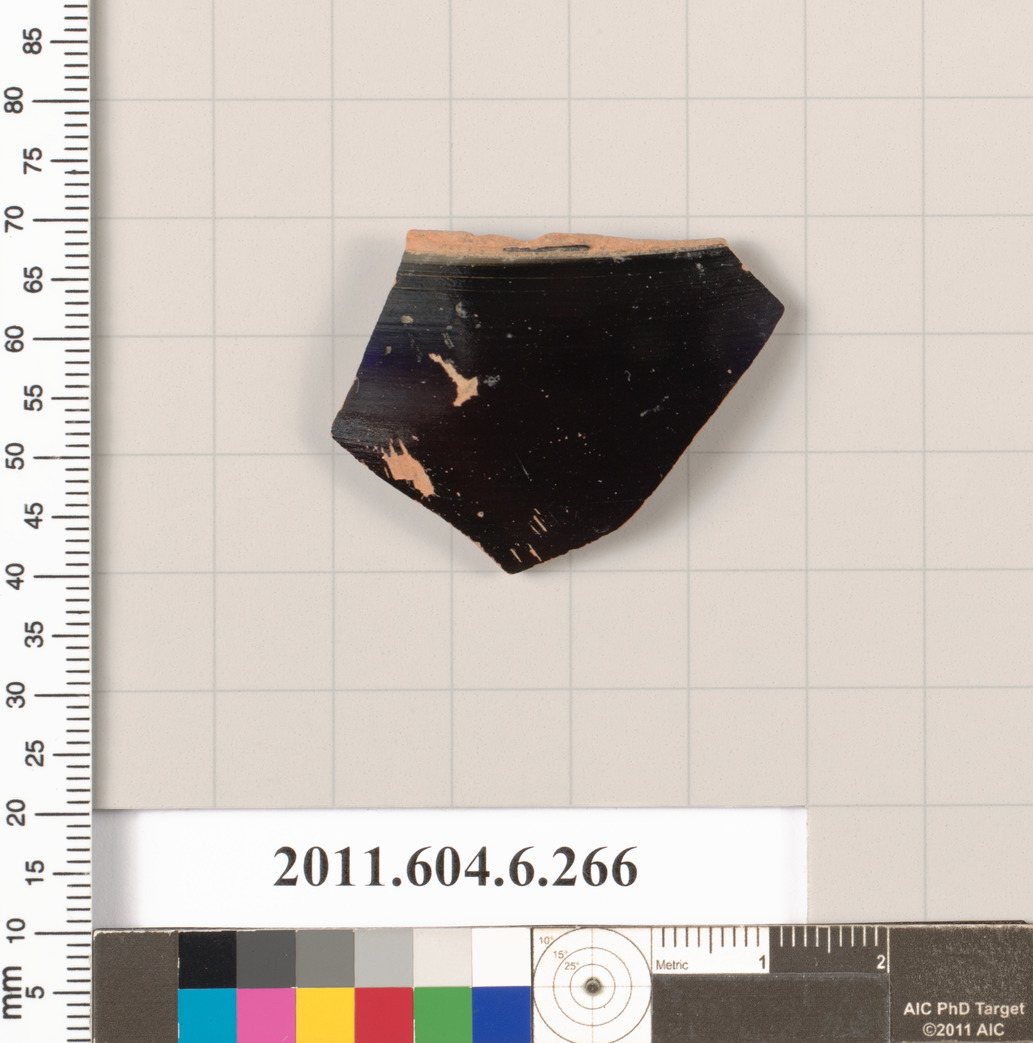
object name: undetermined open shape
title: Terracotta fragment of an open shape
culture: greek, attic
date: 500-401 BCE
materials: terracotta